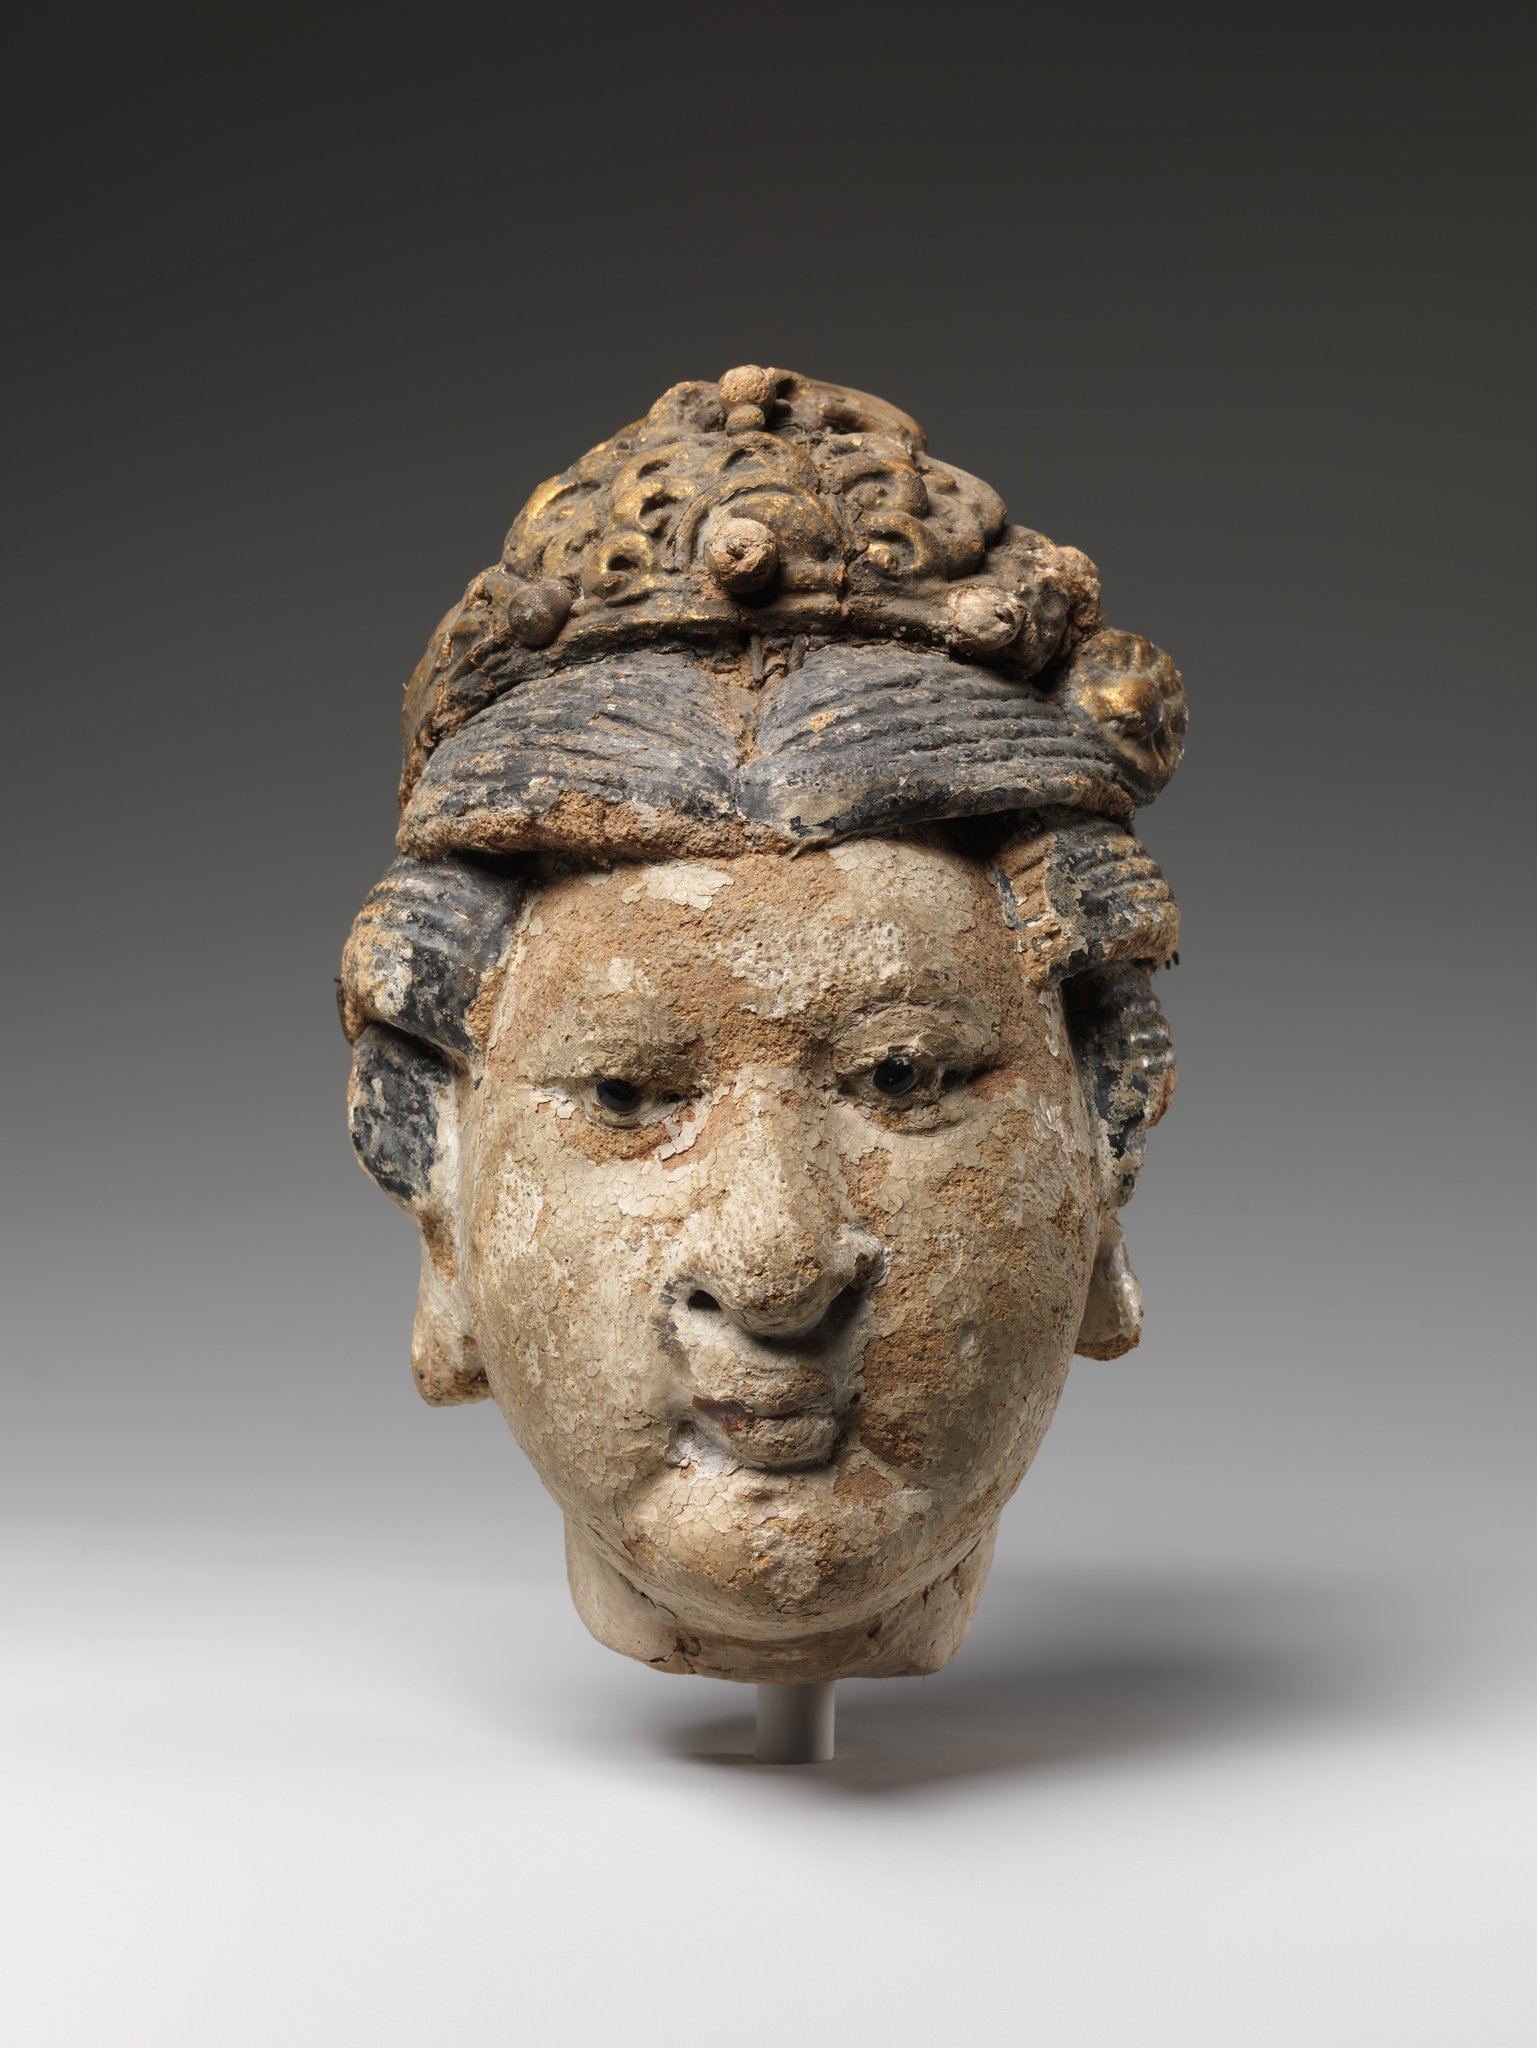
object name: head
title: Head of Attendant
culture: chinese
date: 1001-1200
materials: clay, pigment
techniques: gilding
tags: heads